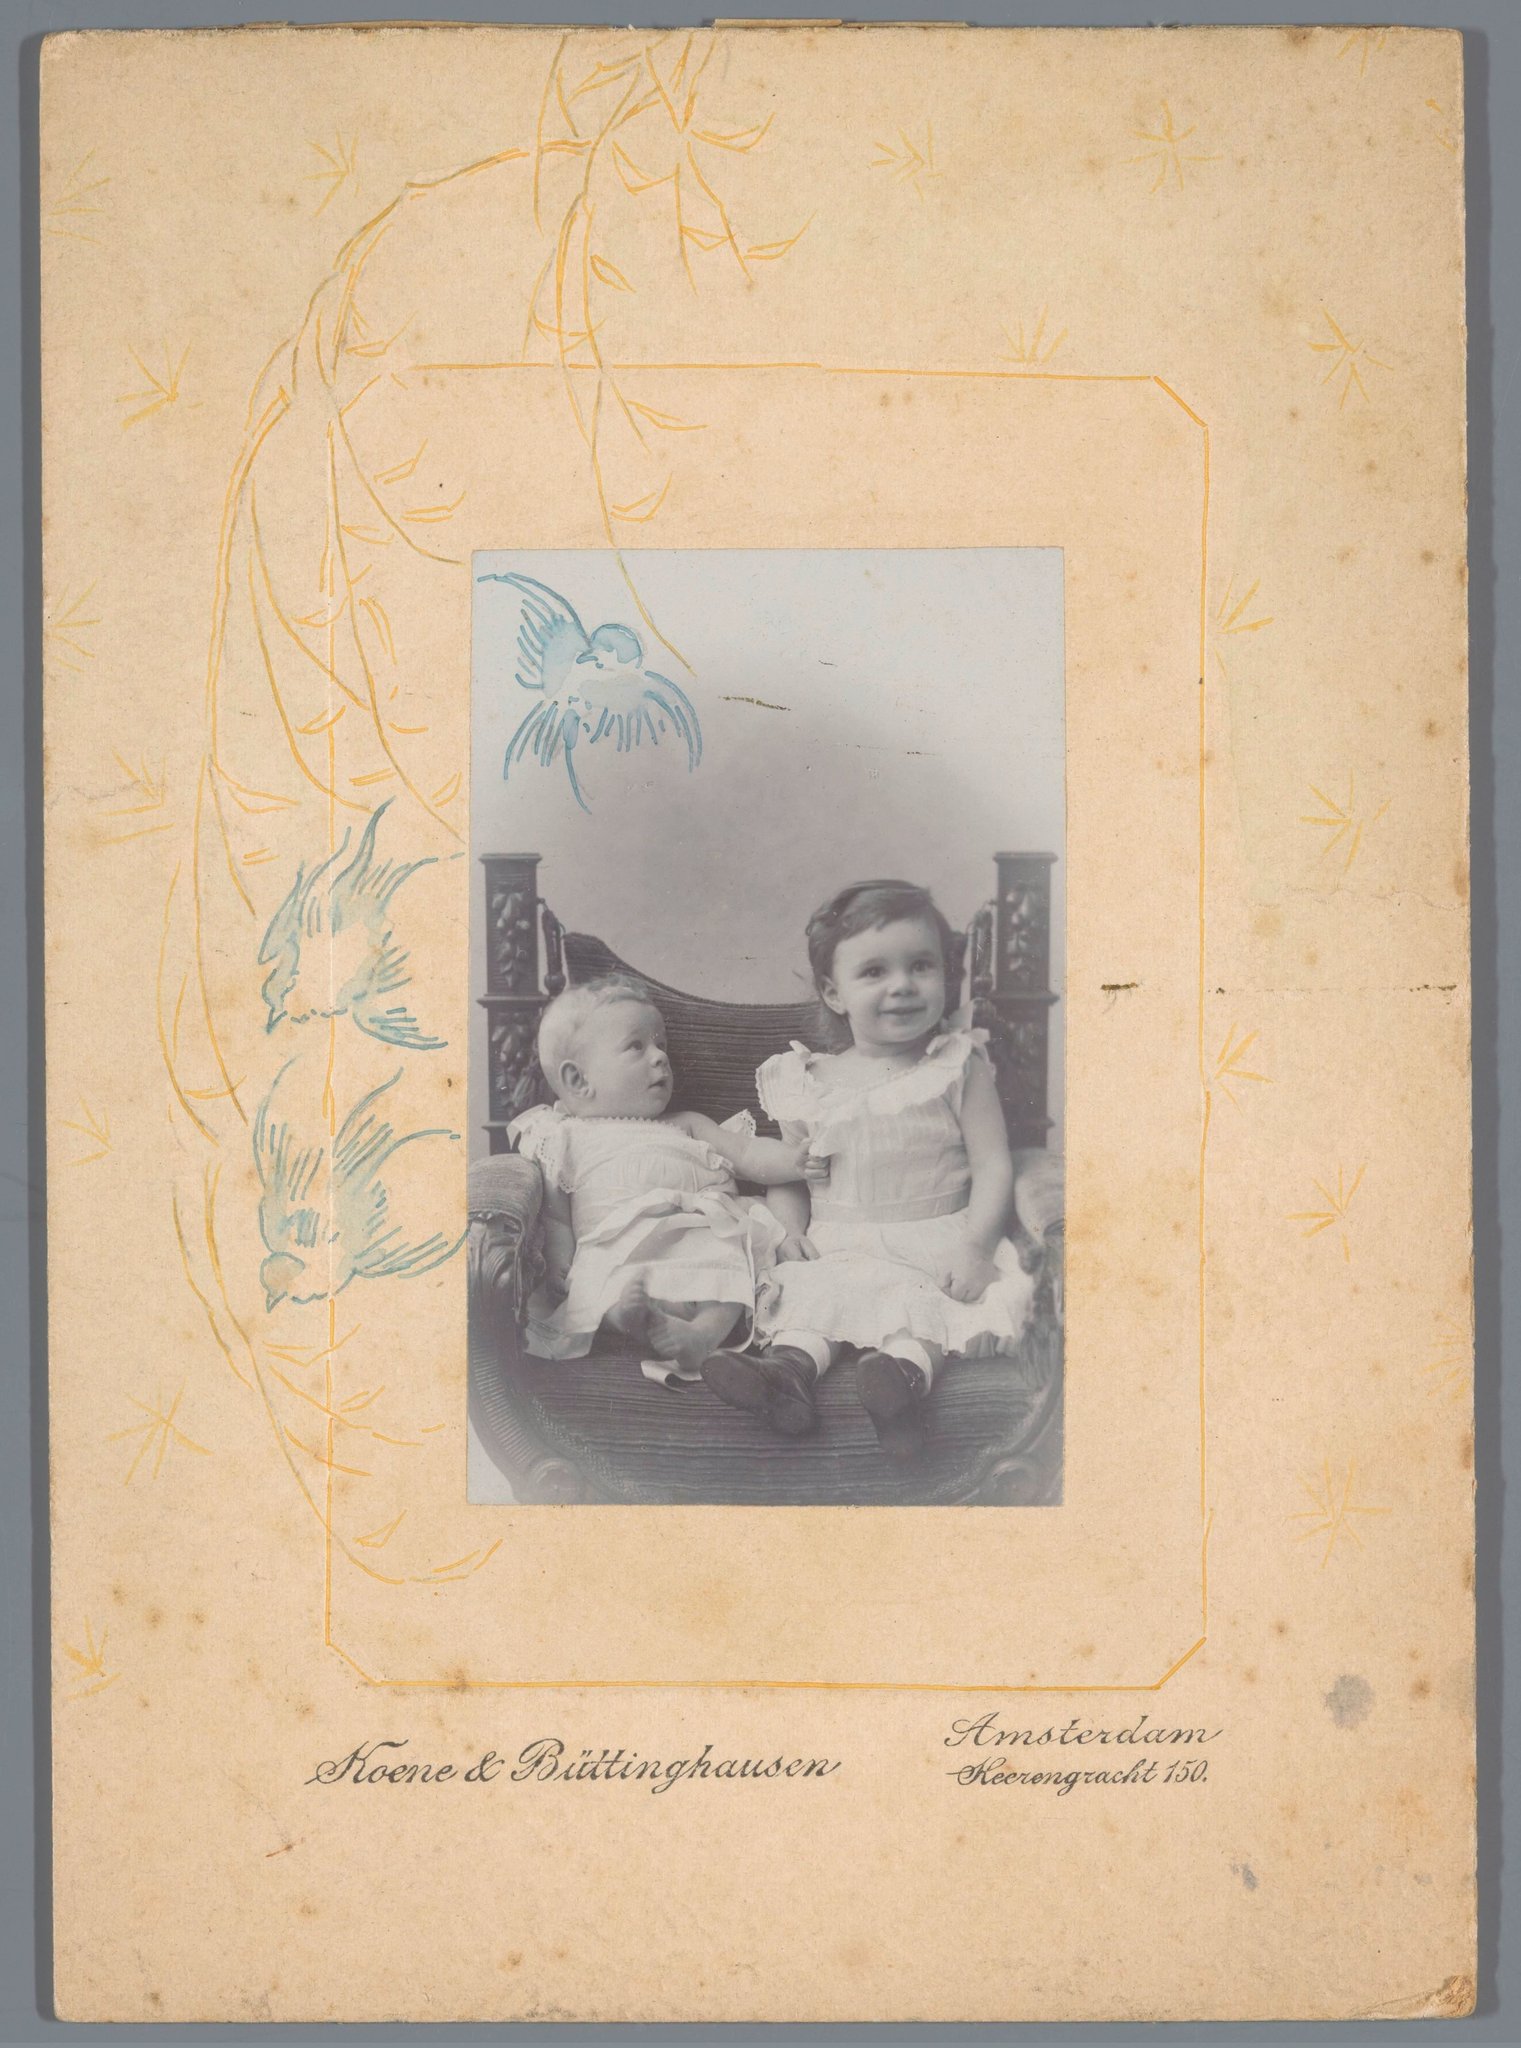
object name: photograph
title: Portret van twee kinderen op een stoel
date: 1905-1920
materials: cardboard, photographic support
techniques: gelatin silver print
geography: amsterdam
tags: child, chair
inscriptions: inscription: ‘Koene & Büttinghausen Amsterdam Heerengracht 150.’